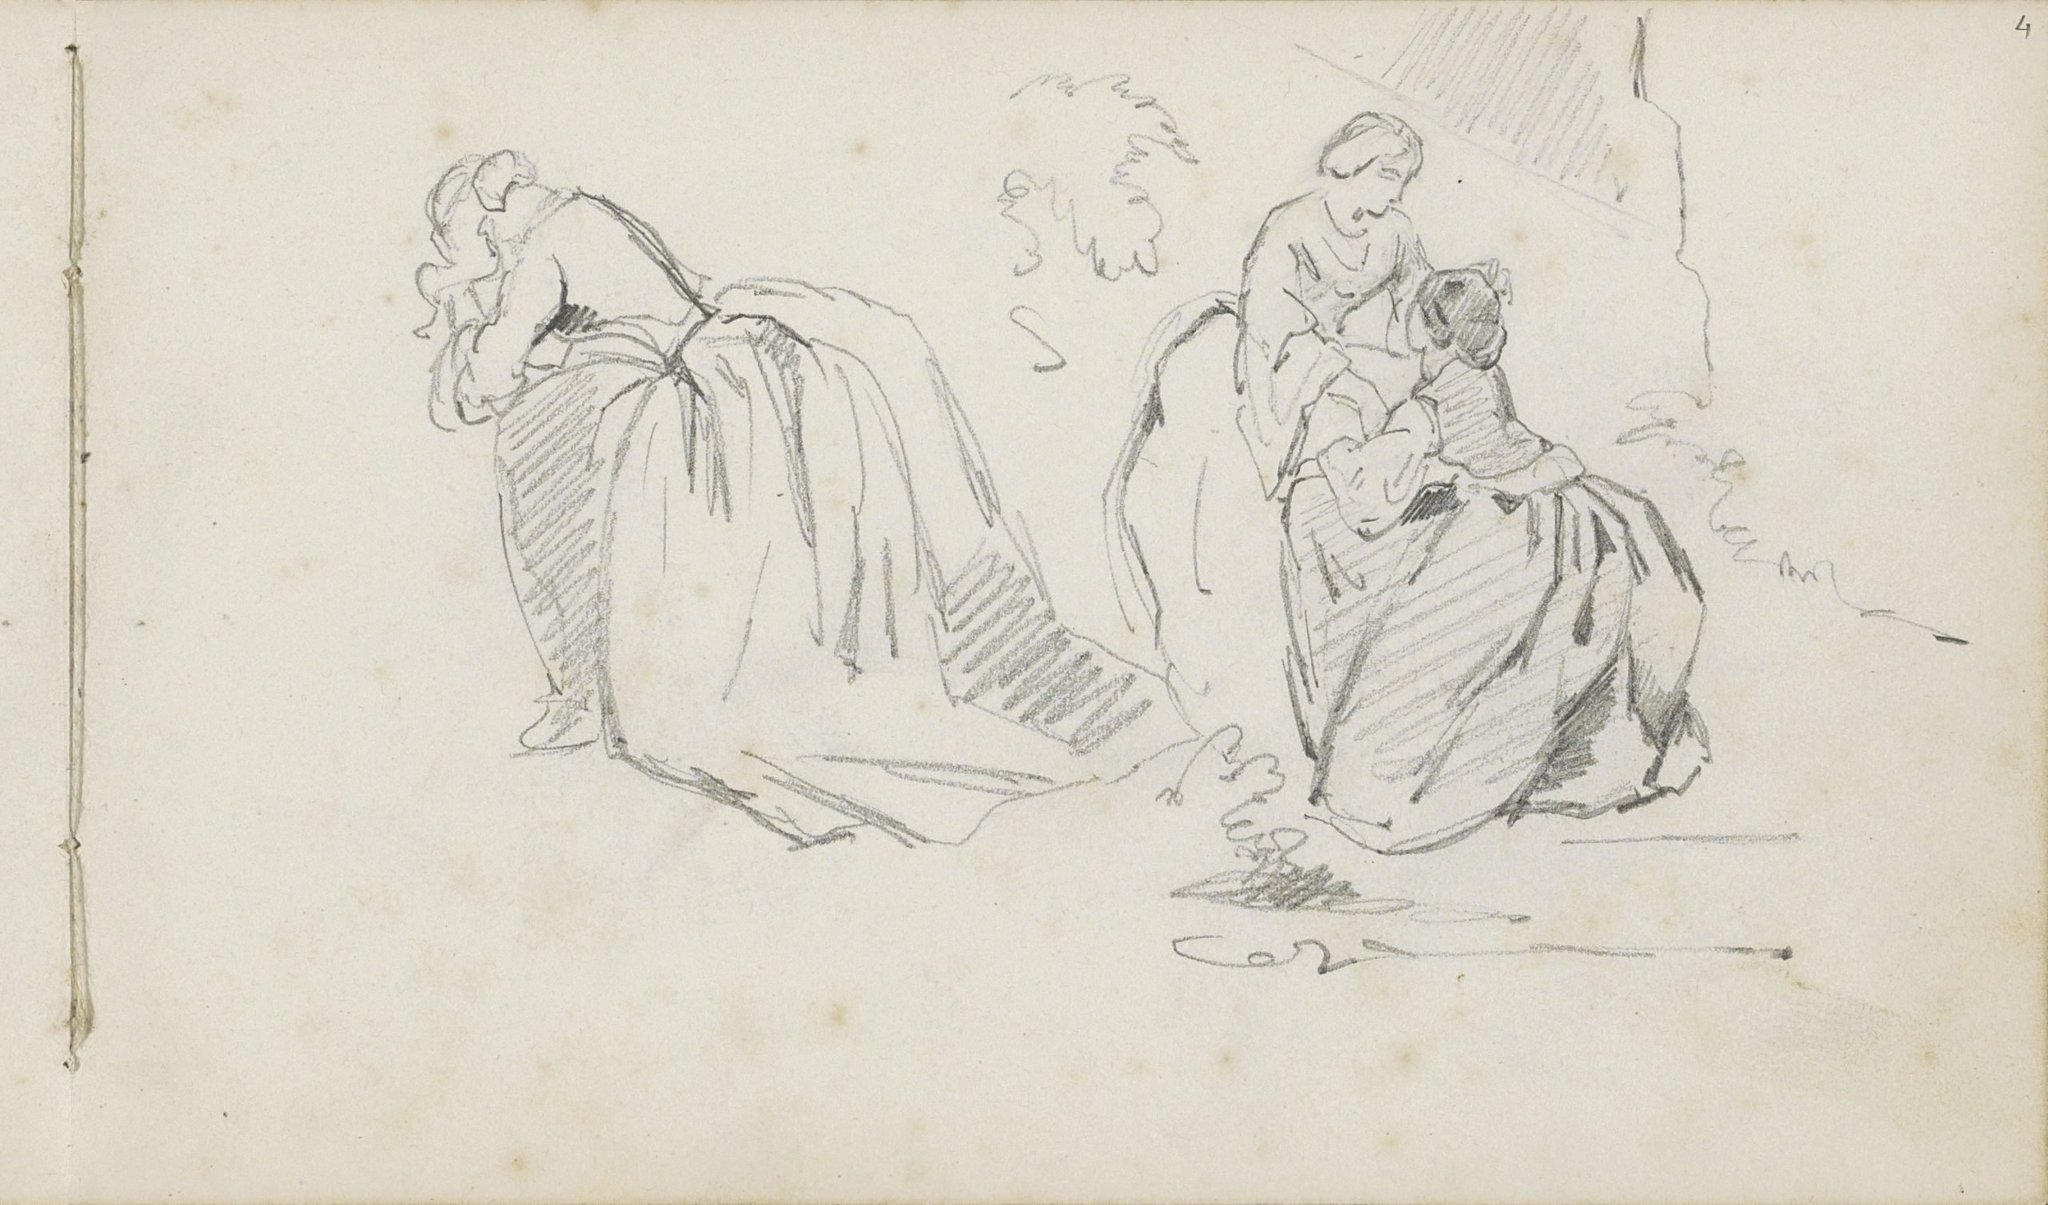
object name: sketchbook leaf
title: Voorovergebogen vrouw en een vrouw en meisje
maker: charles rochussen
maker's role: draughtsman, painter, print maker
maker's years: 1814-1894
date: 1840-1860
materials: paper, pencil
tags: bending figure - aa - female human figure, girl (child between toddler and youth)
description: De vrouw buigt zich voorover en zit met de handen in het haar. Tevens een studie van een meisje dat knielt bij een vrouw. Op de achtergrond gebladerte. Blad 4 recto uit een schetsboek met 38 bladen.